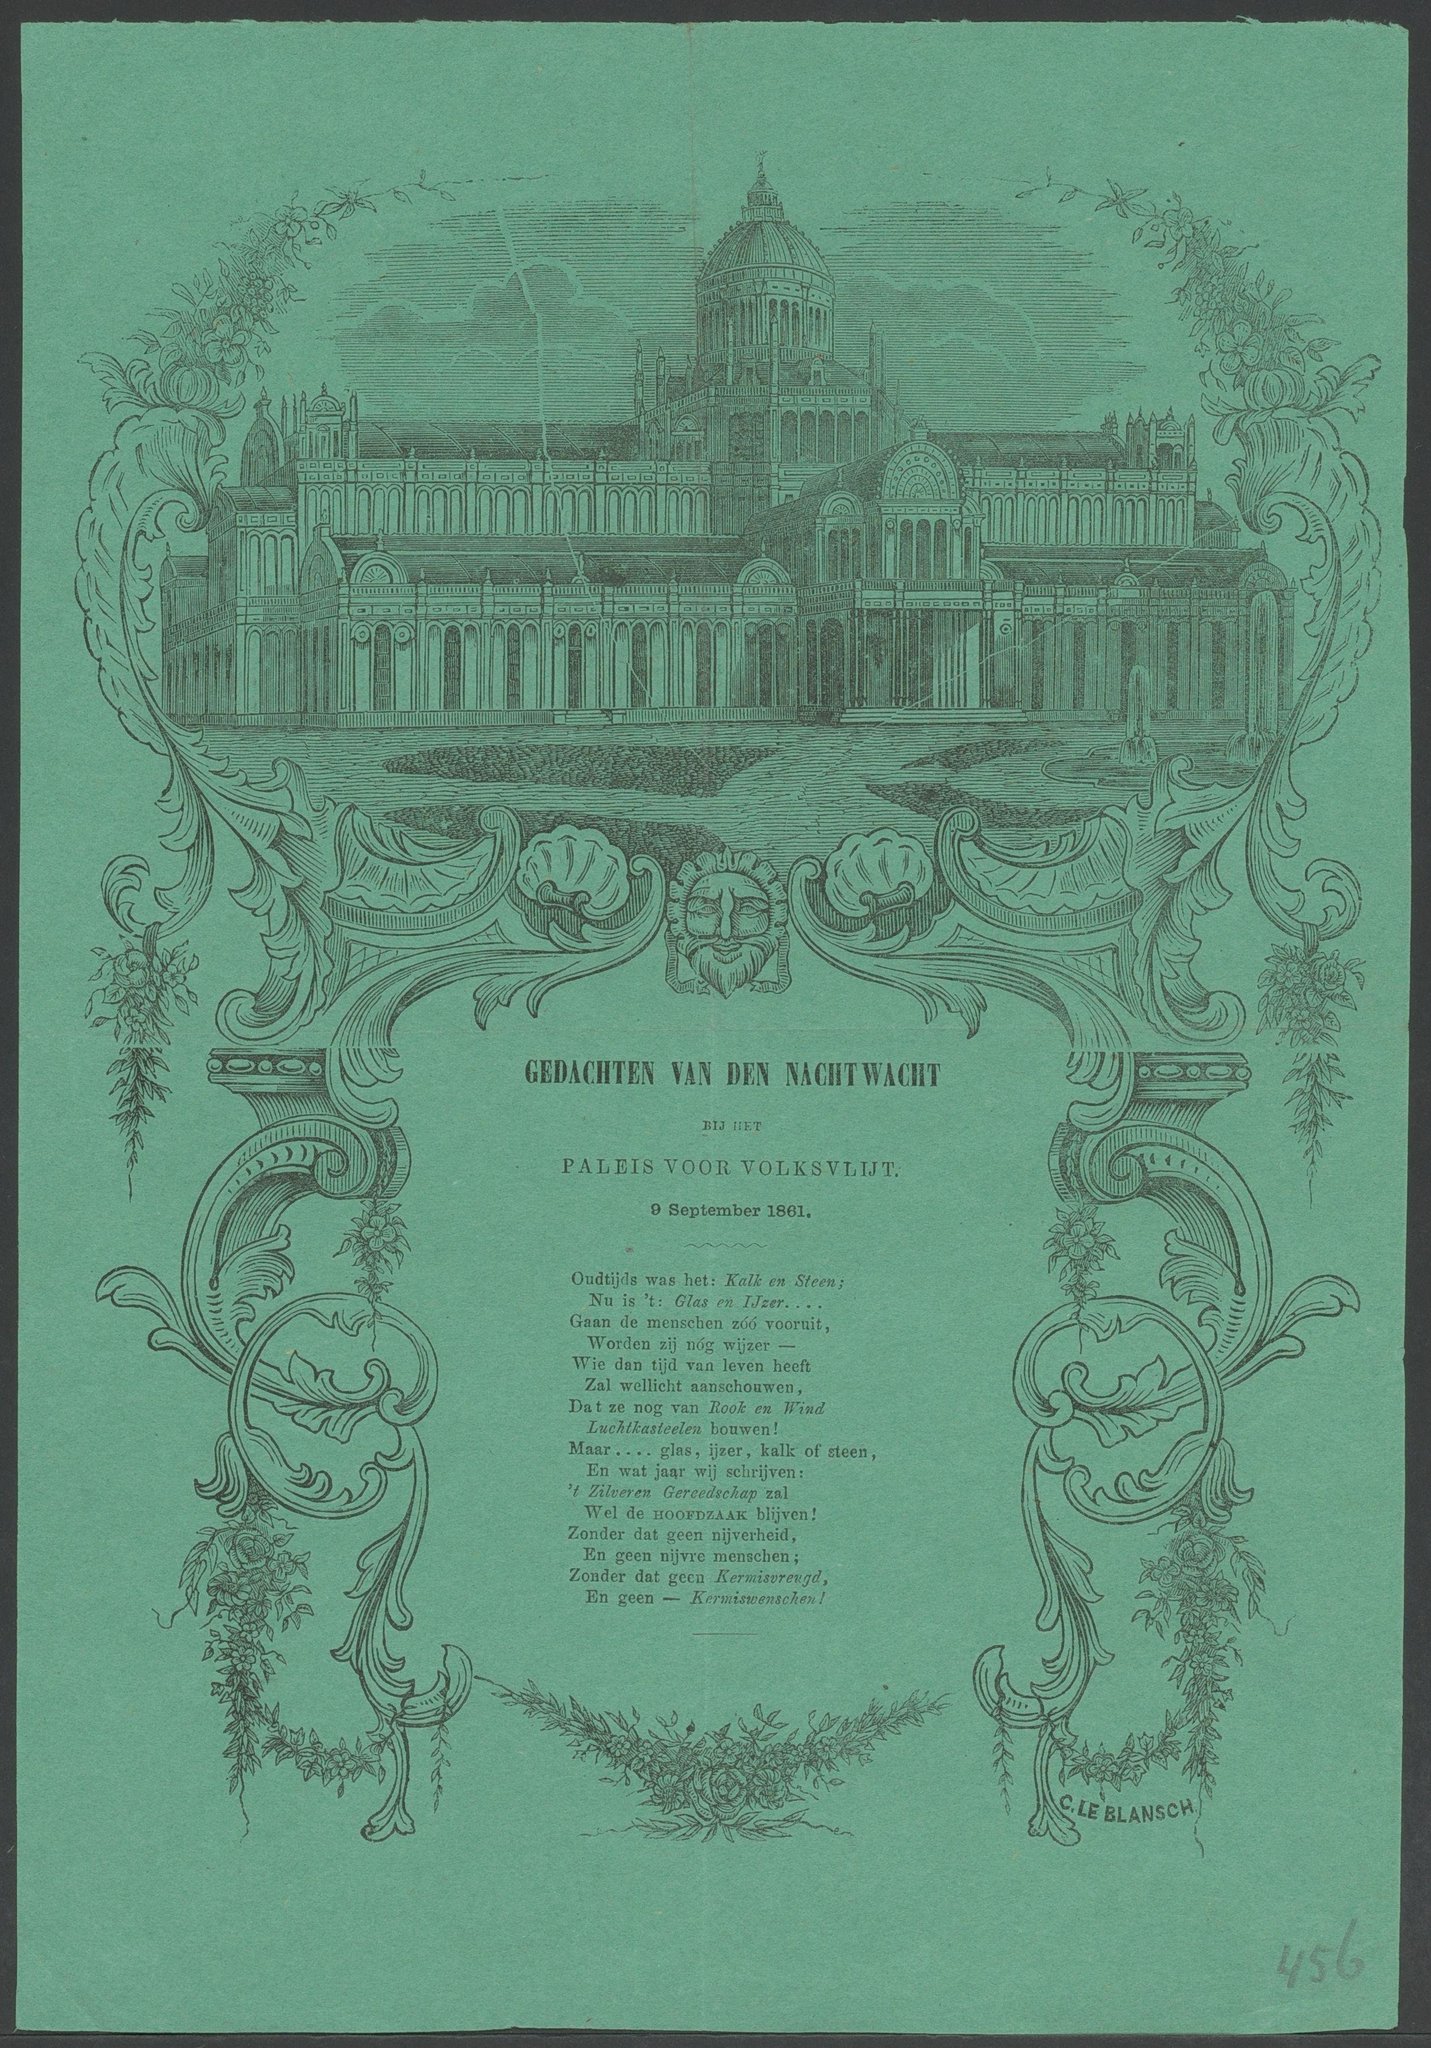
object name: fair print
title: Gedachten van den Nachtwacht bij het Paleis voor Volksvlijt. 9 september 1861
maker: christiaan le blansch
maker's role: print maker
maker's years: 1827-1886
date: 1861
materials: paper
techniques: letterpress printing, engraving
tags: night patrol, pleasure fair and circus, amsterdam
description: Kermisprent van de Amsterdamse nachtwacht (ratelwacht), 9 september 1861. Centraal een gedicht, daarboven het Paleis voor Volksvlijt te Amsterdam. Onderwerpsrubrieken binnen de Atlas Zeden en Gewoonten: Zeden en gewoonten in engeren zin, Volksleven, Volksbladen, Nieuwjaars- en Kerstwenschen, Amsterdam.